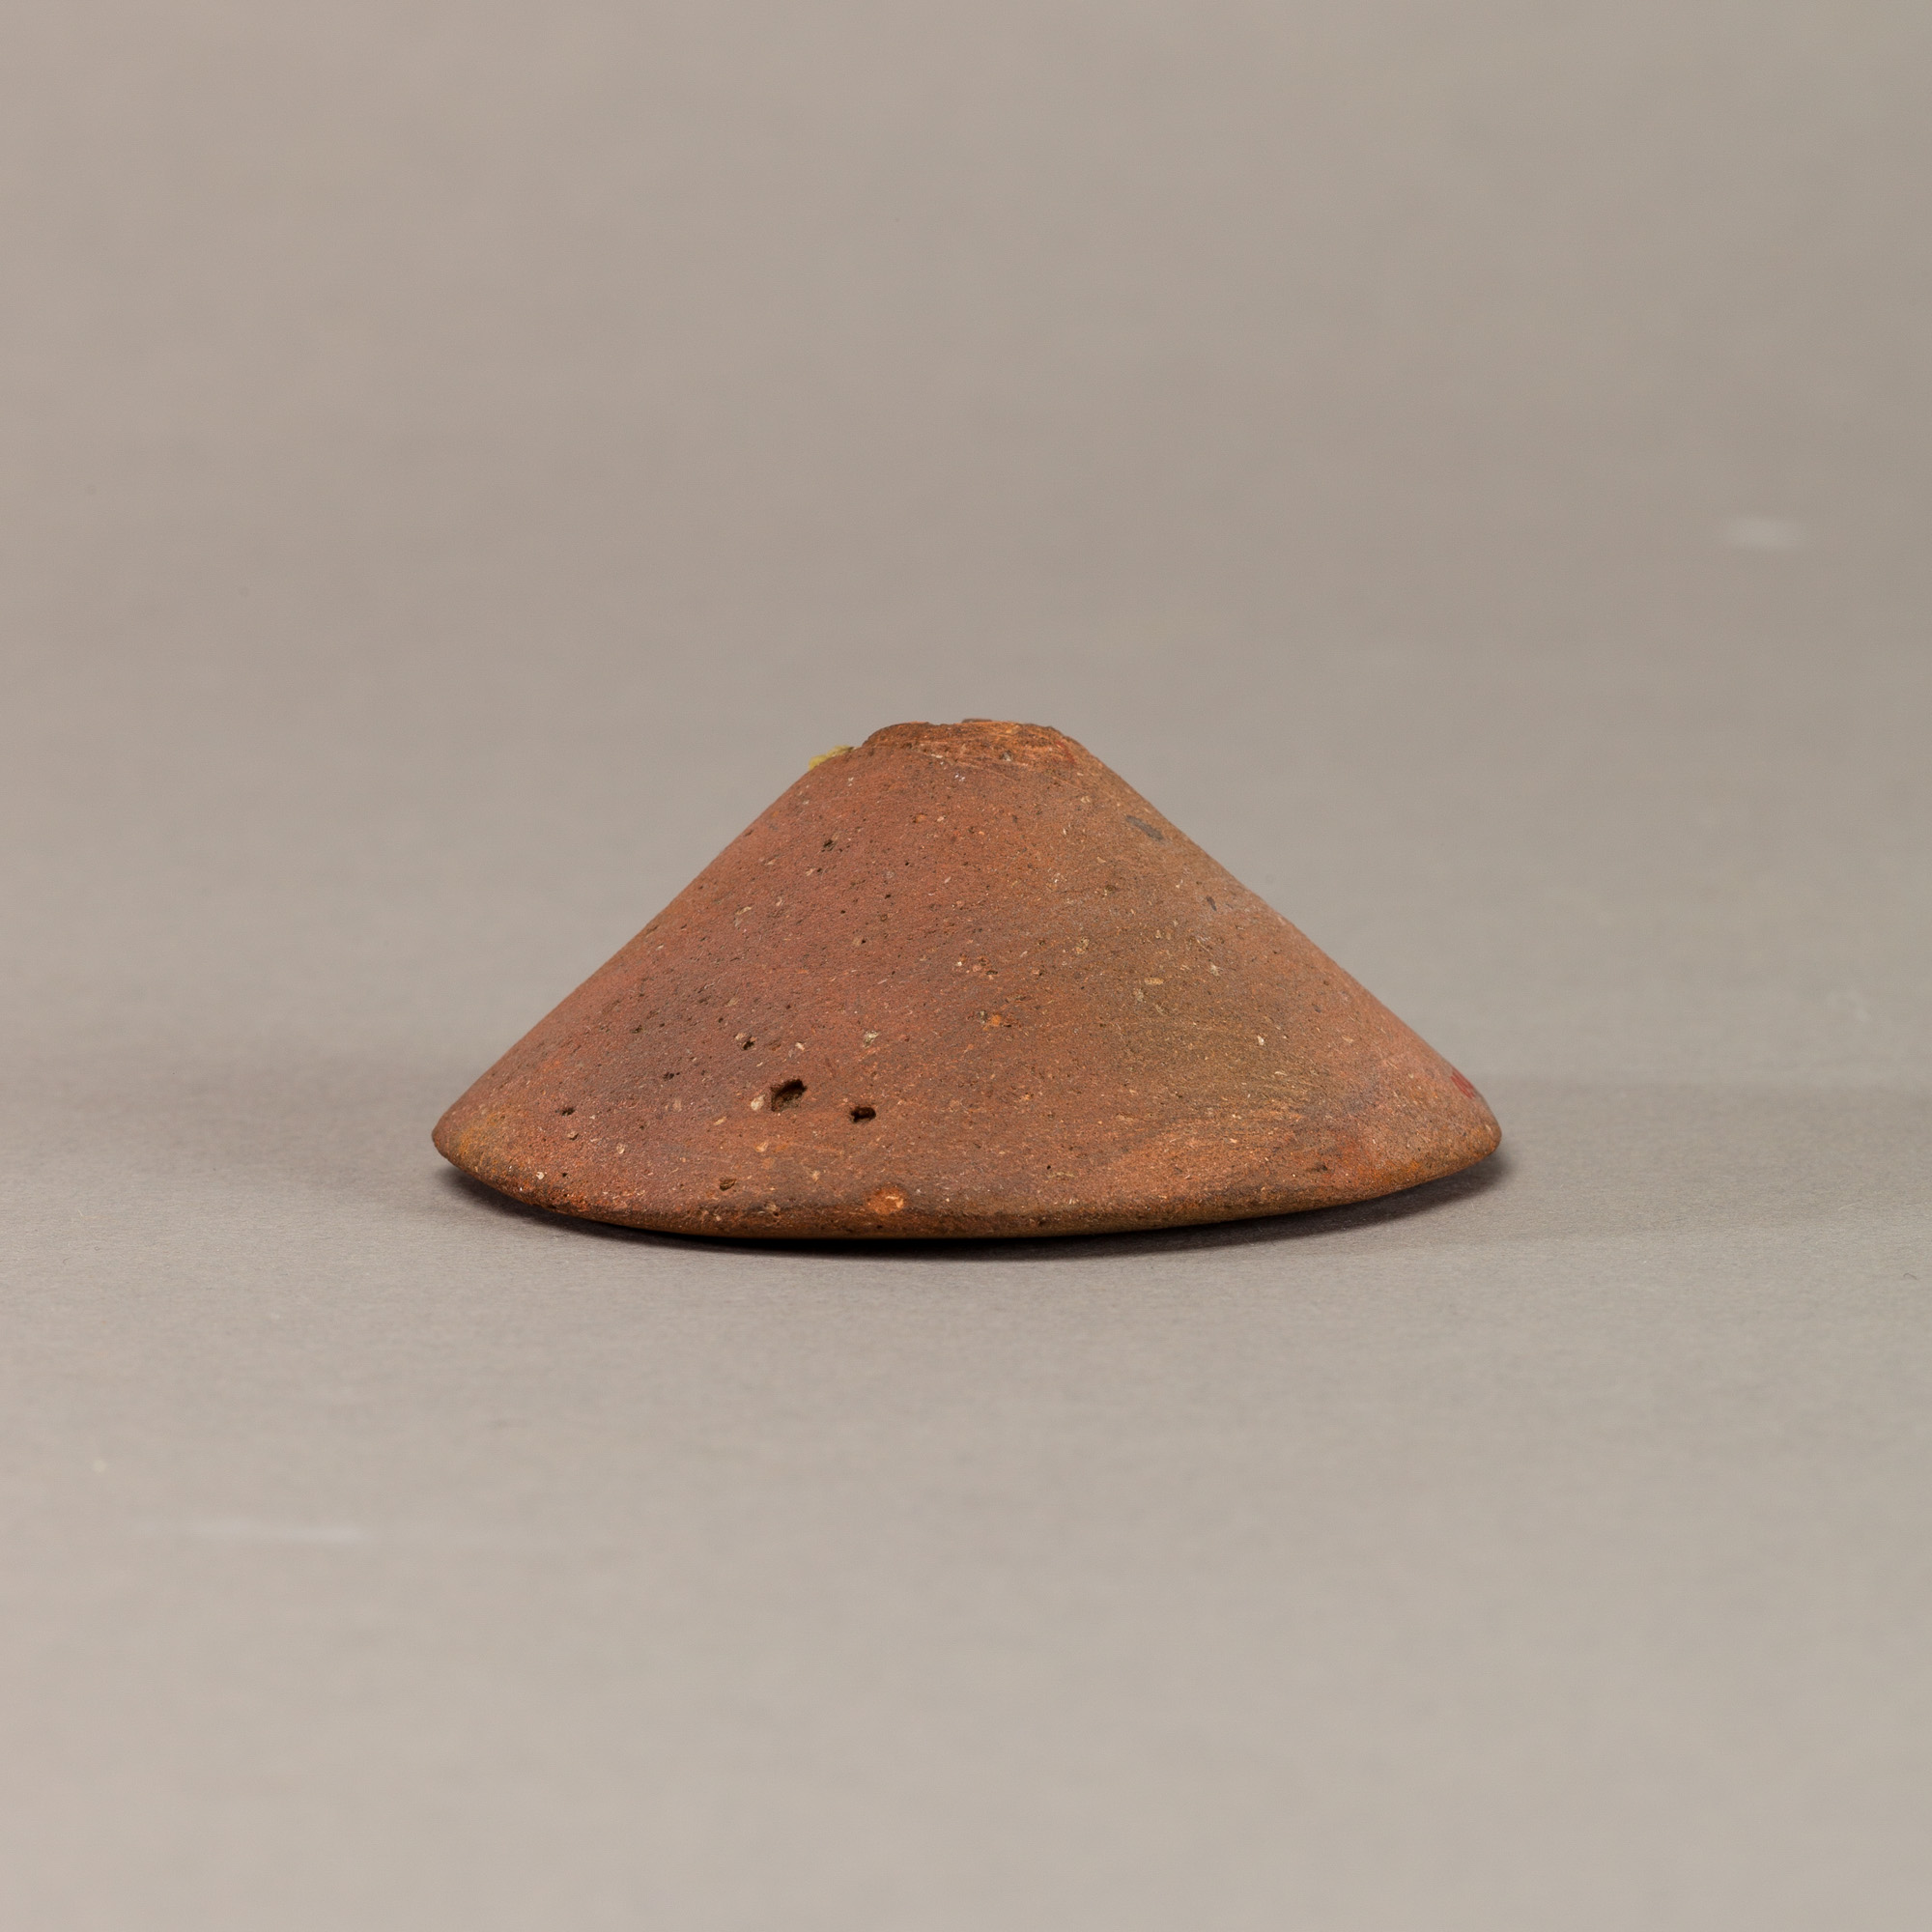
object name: macehead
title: Probably a model macehead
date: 3800-3600 BCE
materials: pottery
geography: egypt